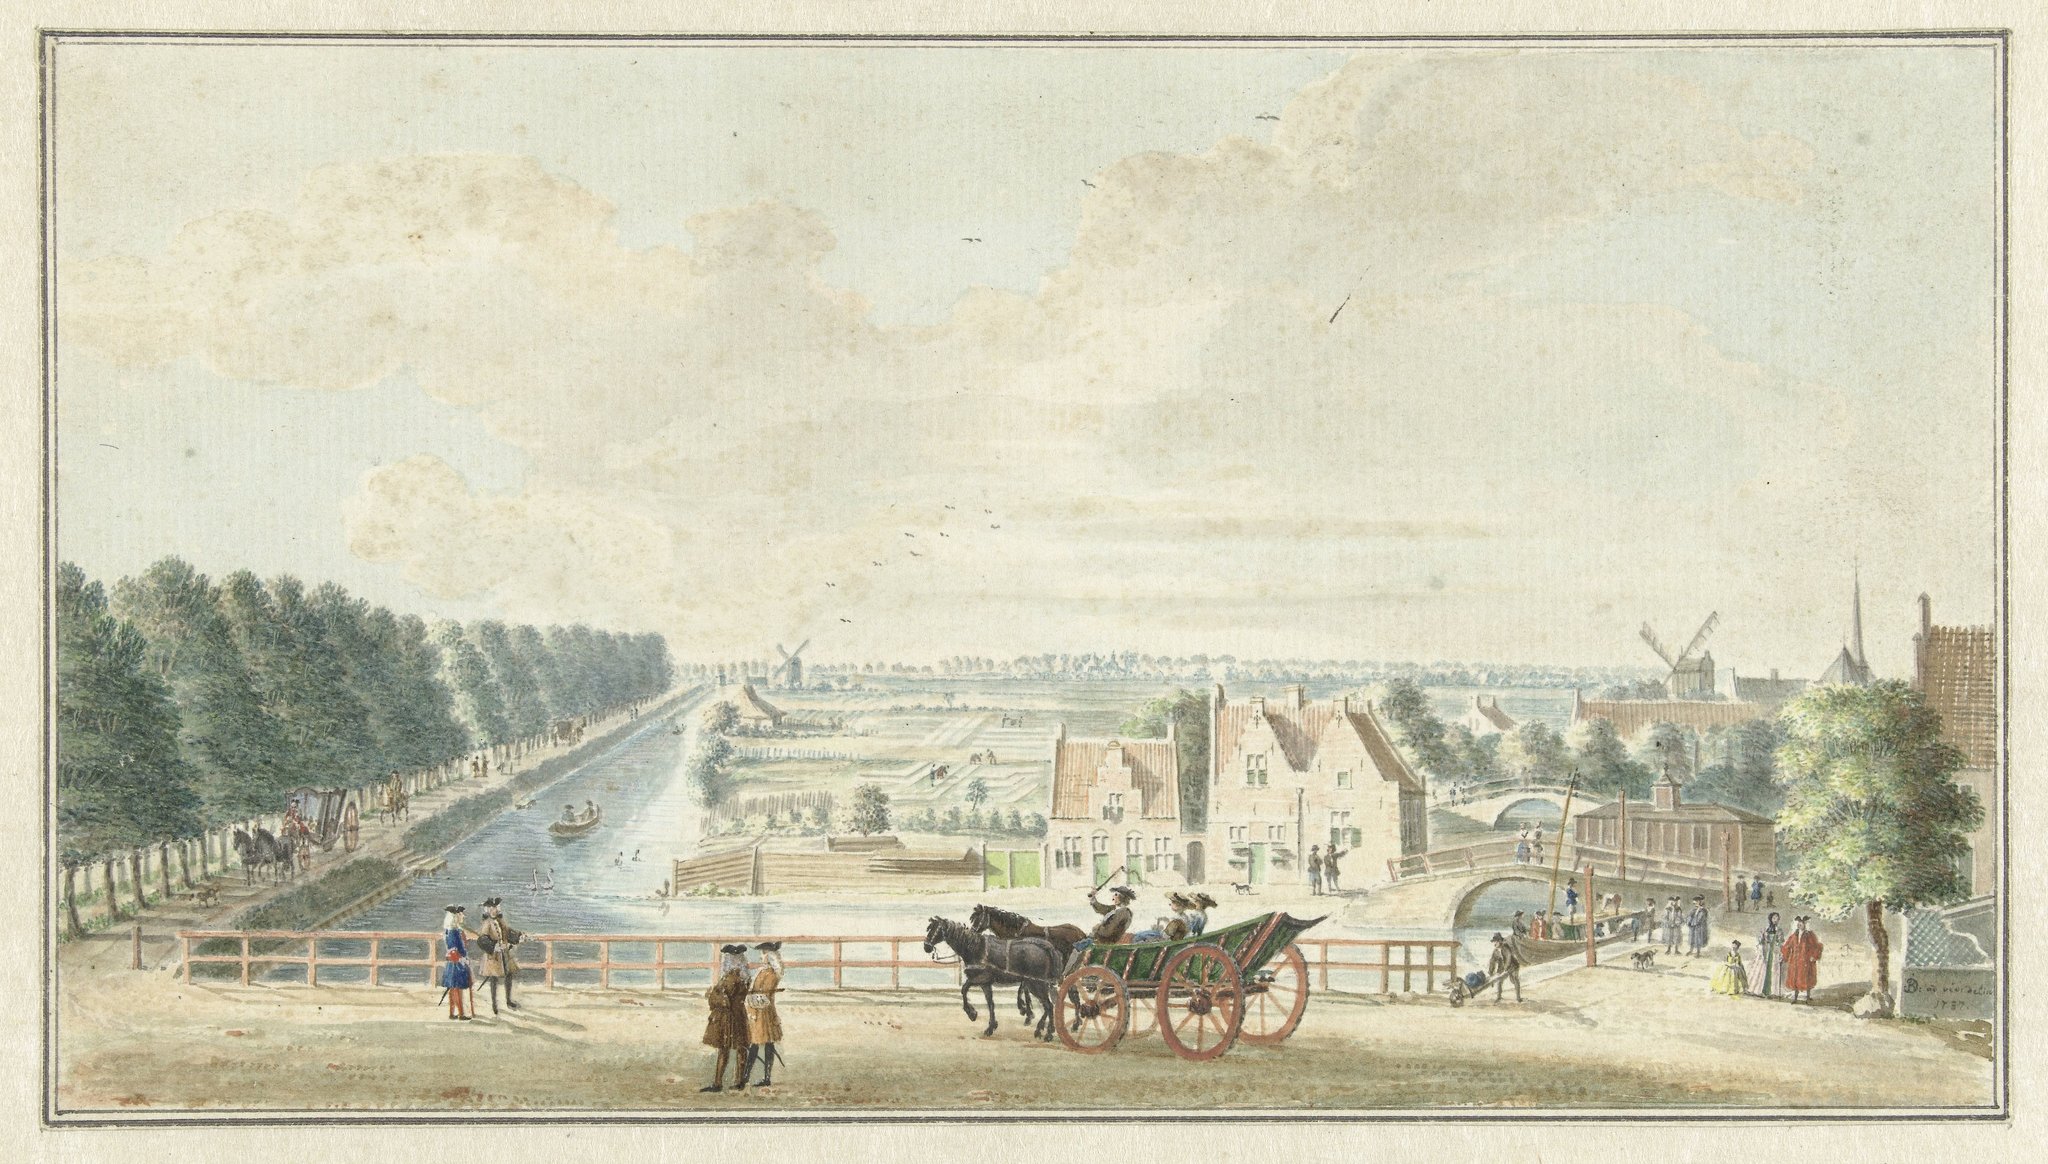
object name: drawing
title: Gezicht van de Wal bij de Catharijnepoort te Utrecht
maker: jan de beijer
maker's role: draughtsman, print maker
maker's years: 1703-1780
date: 1737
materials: ink, paper, watercolor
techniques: brush, pen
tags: city-gate, utrecht